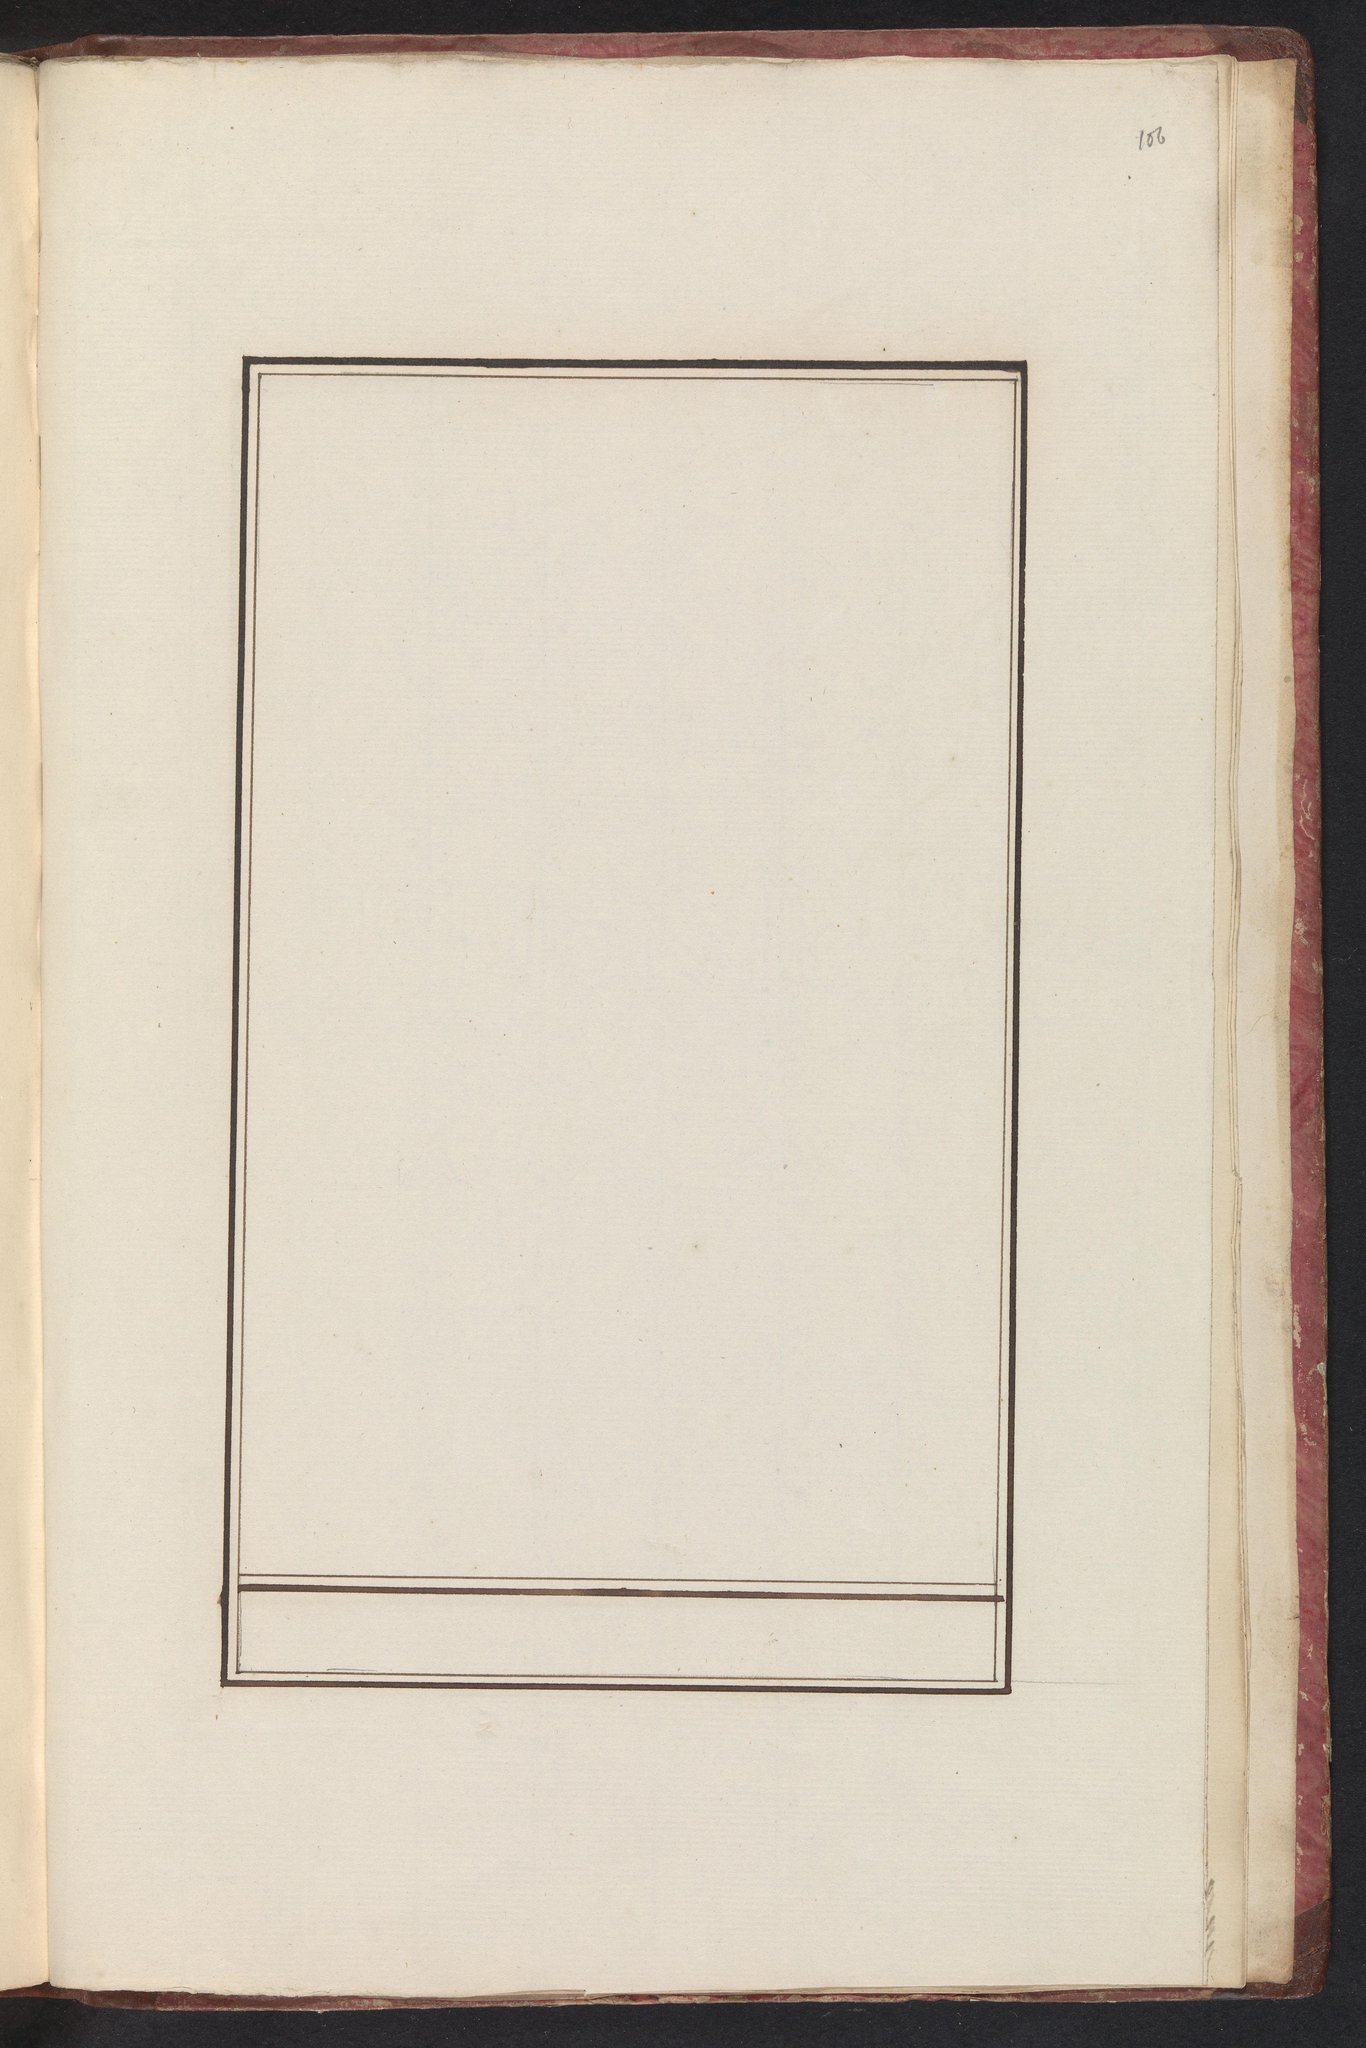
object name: drawing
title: Omlijsting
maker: Anonymous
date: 1809-1814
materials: paper, pencil, watercolor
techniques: brush, pen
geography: southern netherlands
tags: frame of painting, etc.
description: Lege omlijsting. Rechtsboven genummerd: 292. Onderdeel van het derde album met tekeningen van bloemen. Tiende van twaalf albums met tekeningen van dieren, vogels en planten bekend rond 1600, gemaakt in opdracht van keizer Rudolf II. Met toelichting in Nederlands, Latijn en Frans.